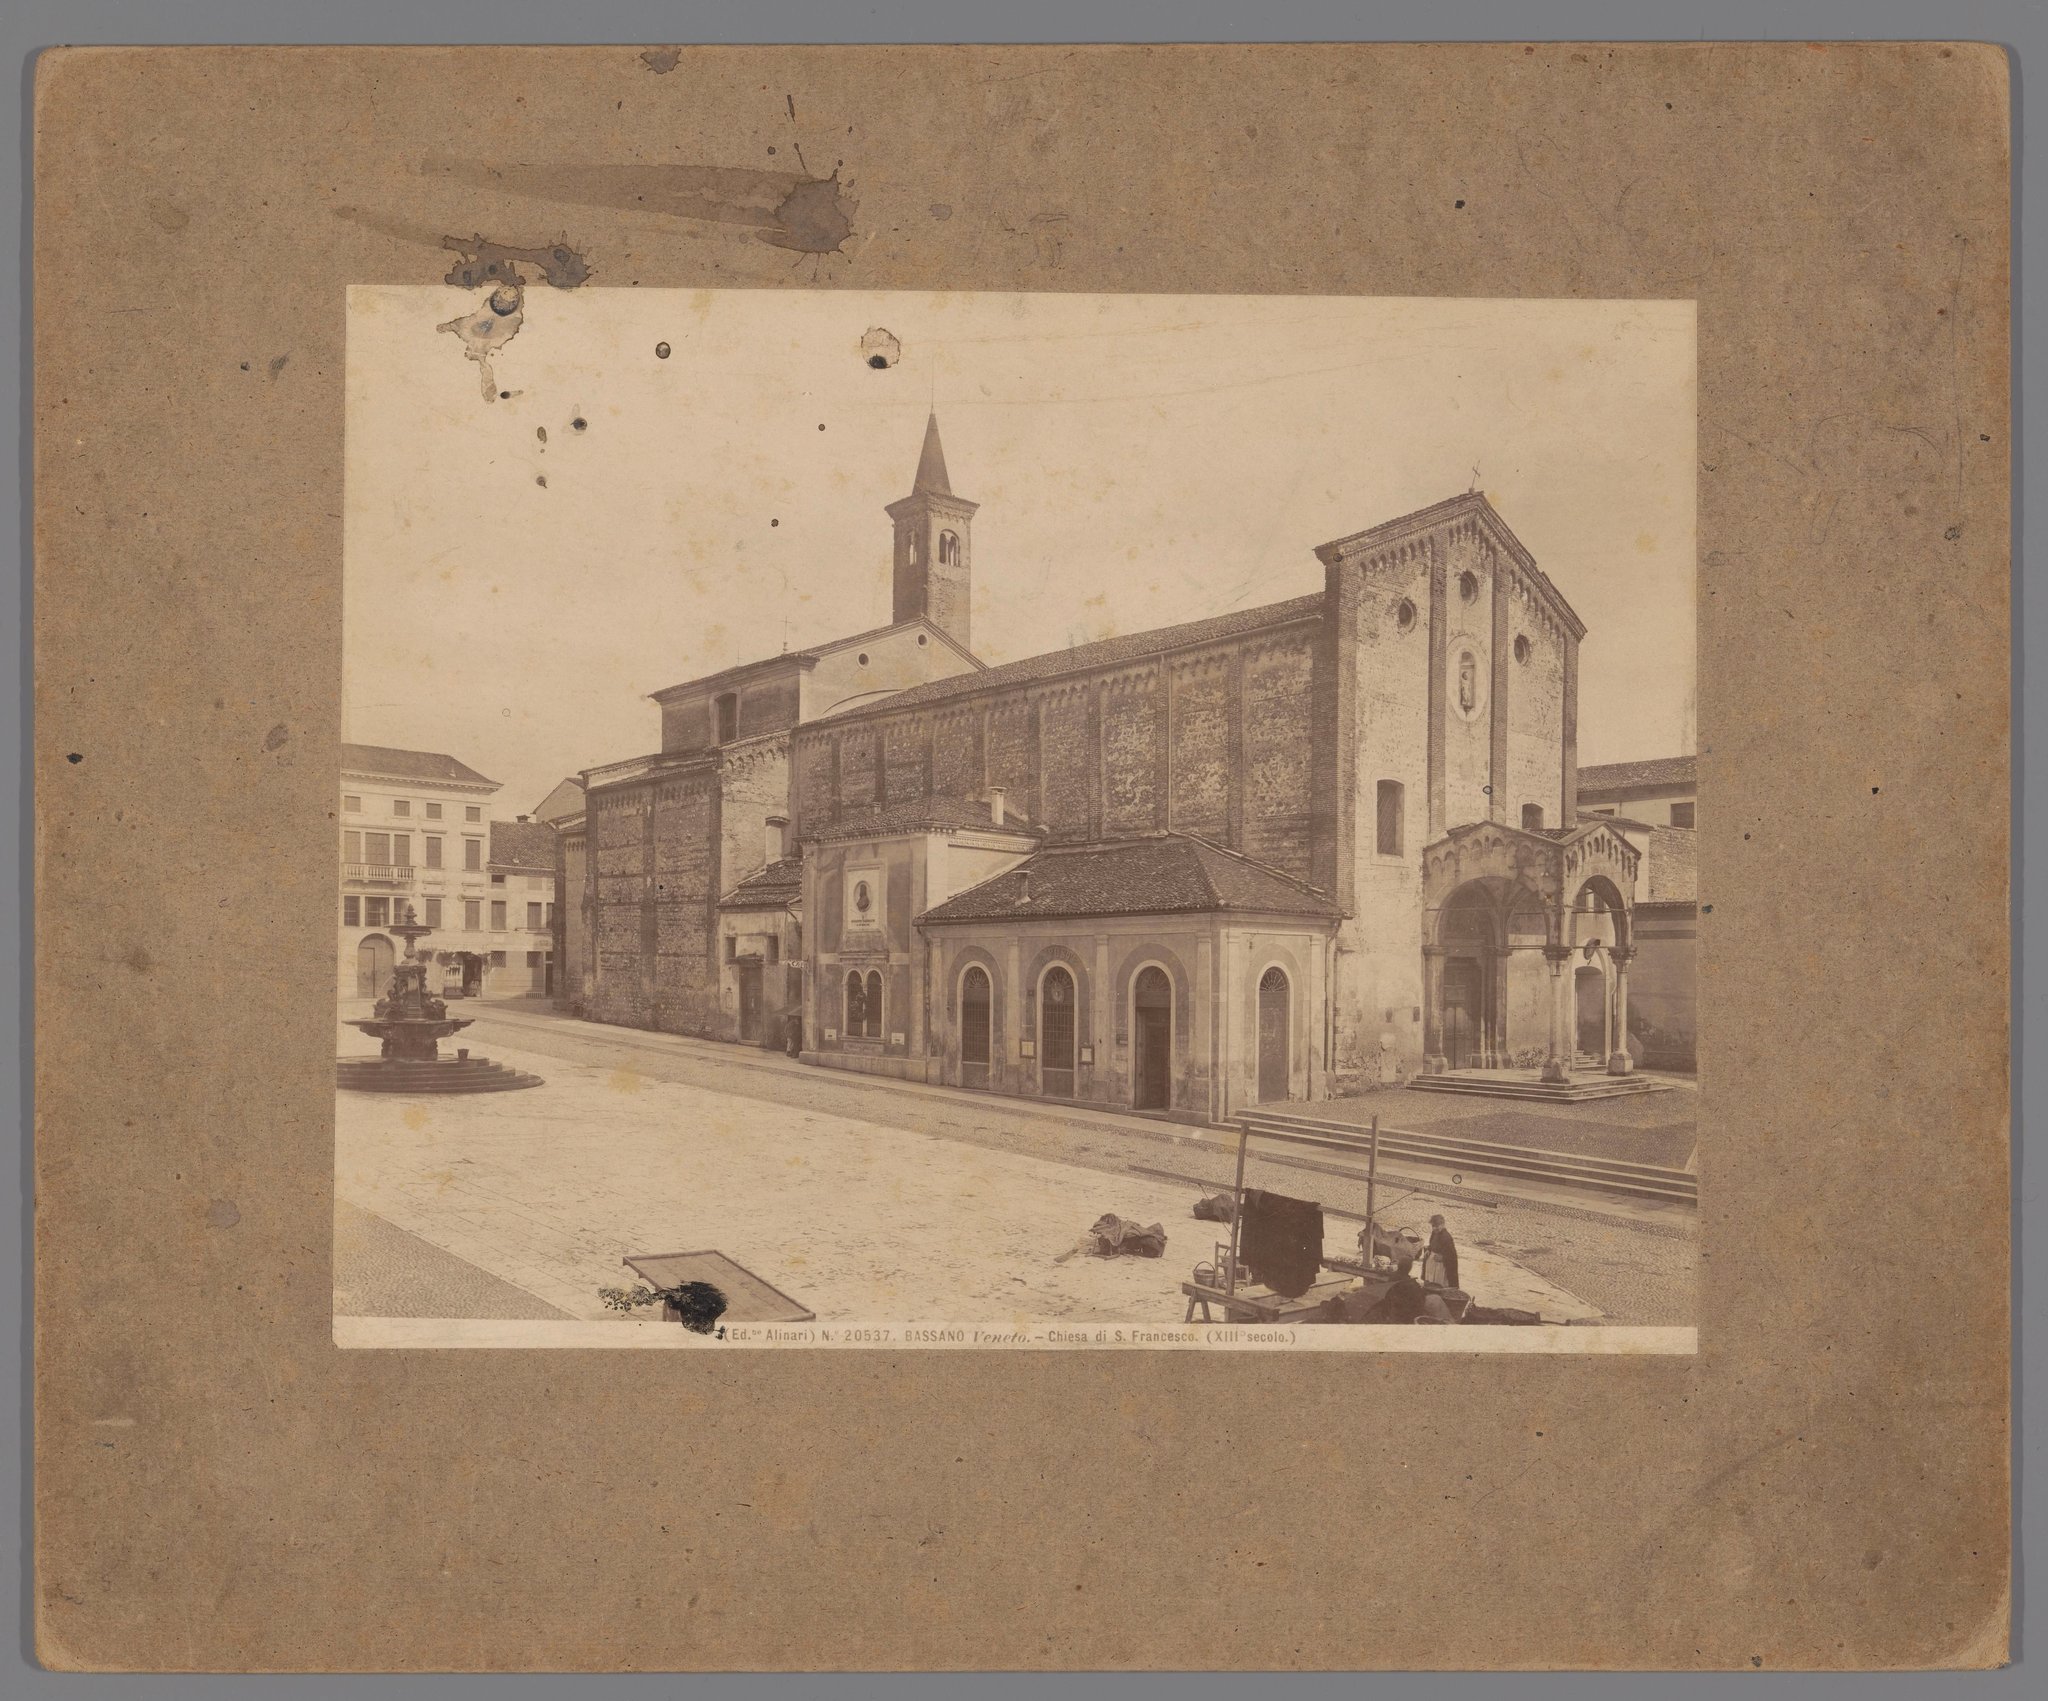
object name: photograph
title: Exterieur van de Sint-Franciscuskerk te Bassano del Grappa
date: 1875-1900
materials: cardboard, photographic support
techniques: albumen print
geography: bassano del grappa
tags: church (exterior), façade (of house or building)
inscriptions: number: ‘No. 20537.’, collector's mark: Lugt 3937